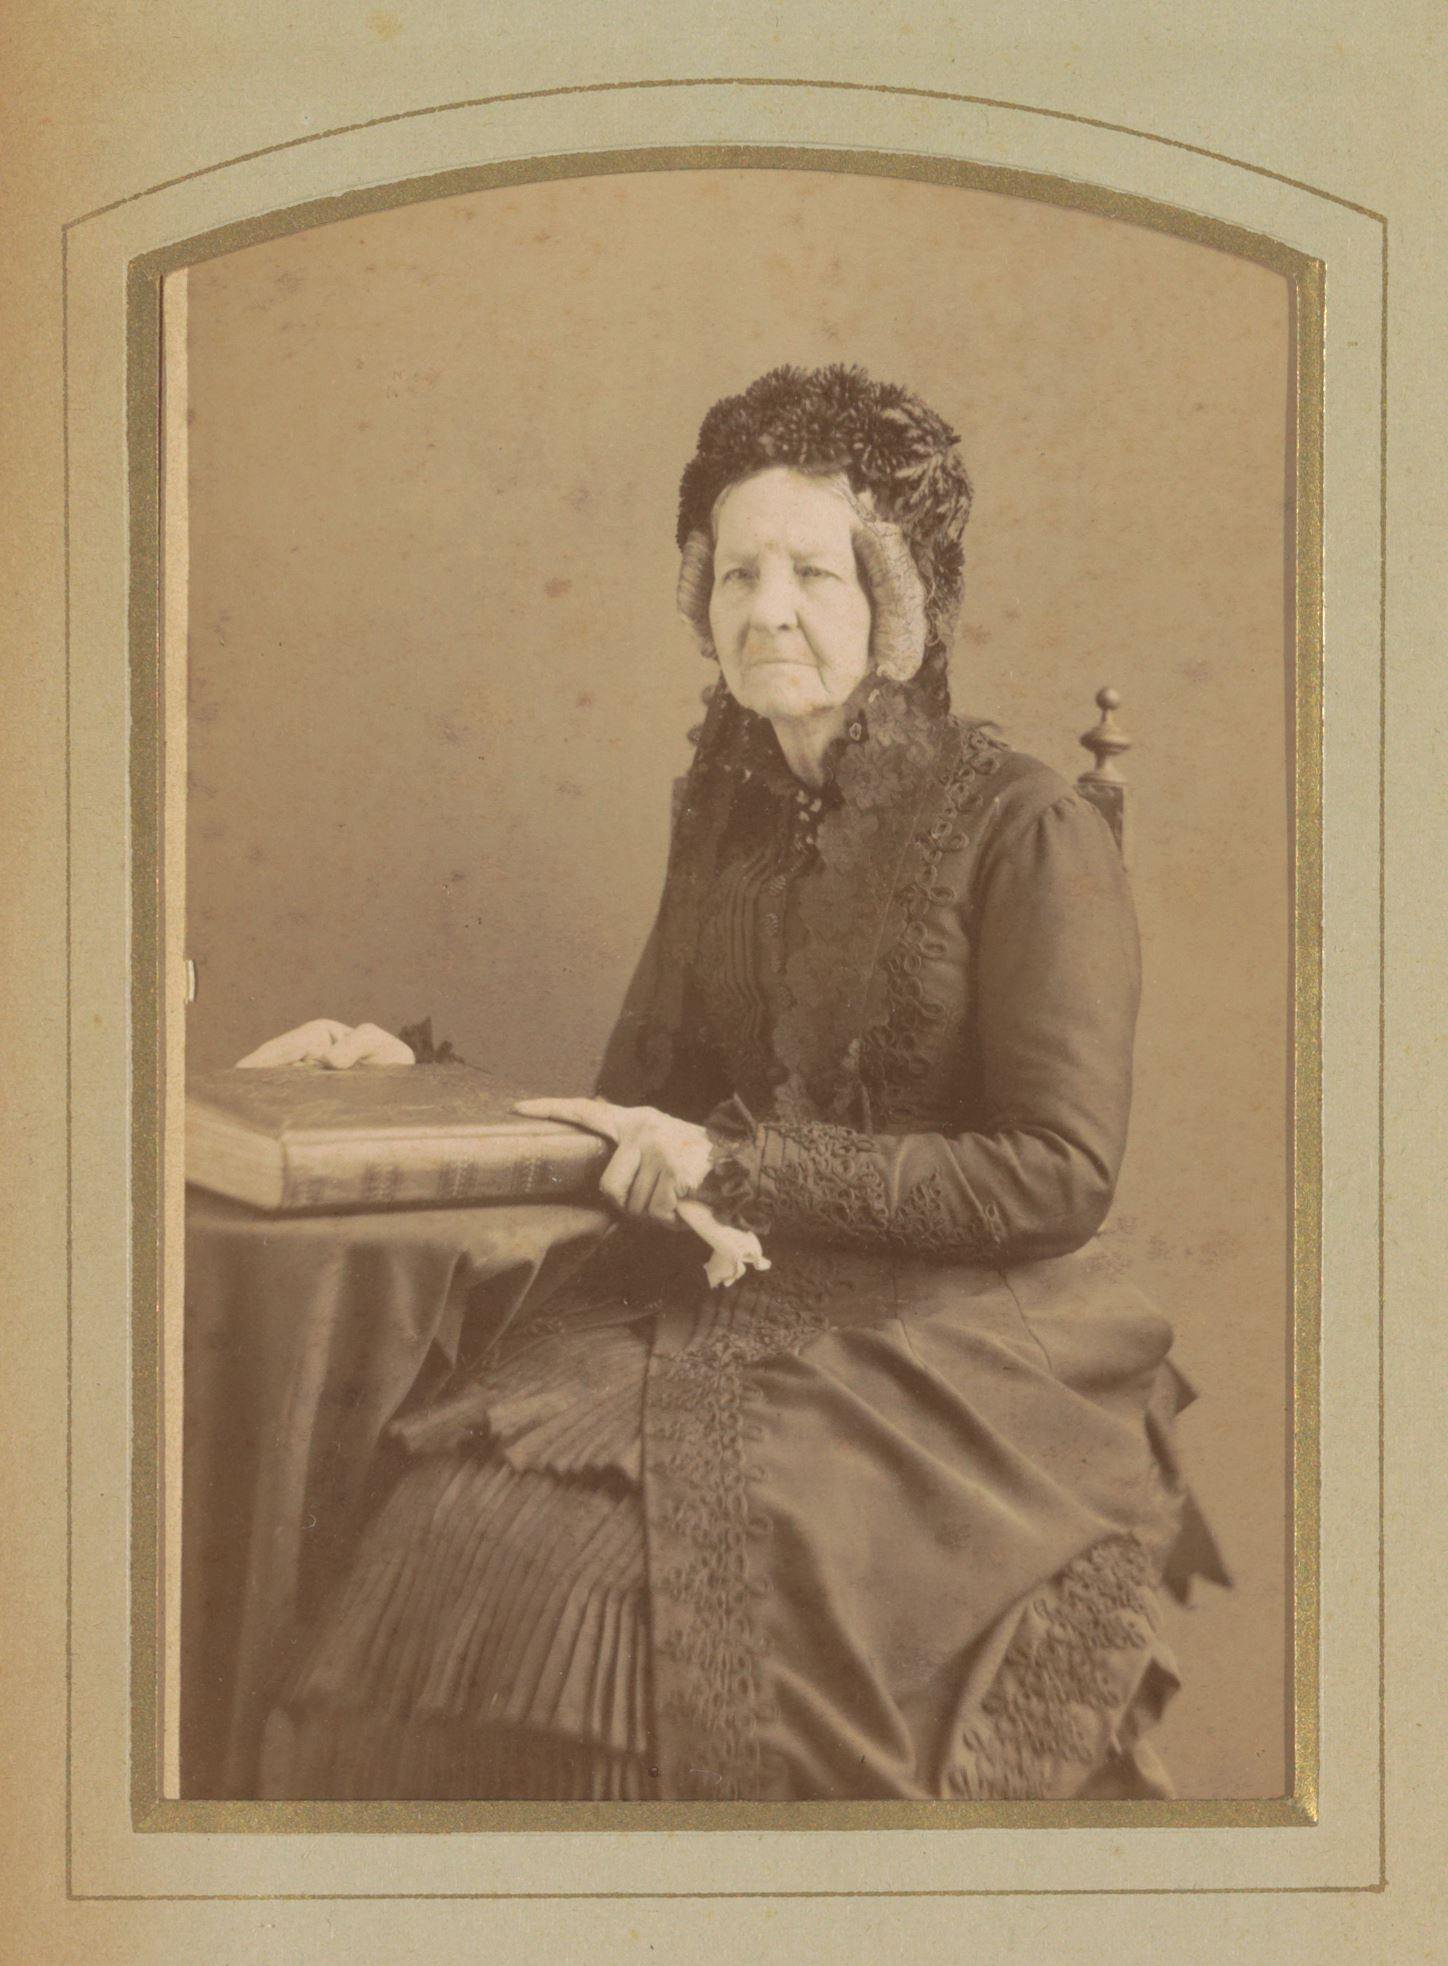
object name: cabinet photograph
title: Portret van mevrouw Boelen-Waller, zittend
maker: henri de paauw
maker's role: fotograaf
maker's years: 1849-1922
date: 1882-1903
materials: cardboard, paper, photographic support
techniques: albumen print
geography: hilversum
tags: adult woman, studio requisites ~ photographer, historical persons - bb - woman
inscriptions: inscription: ‘Mr. Schmidt van Gelder Singel 42 Amsterdam’, address: ‘Hilversum D 362 Kerkstraat’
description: Onderdeel van Fotoalbum van de familie Boelen.